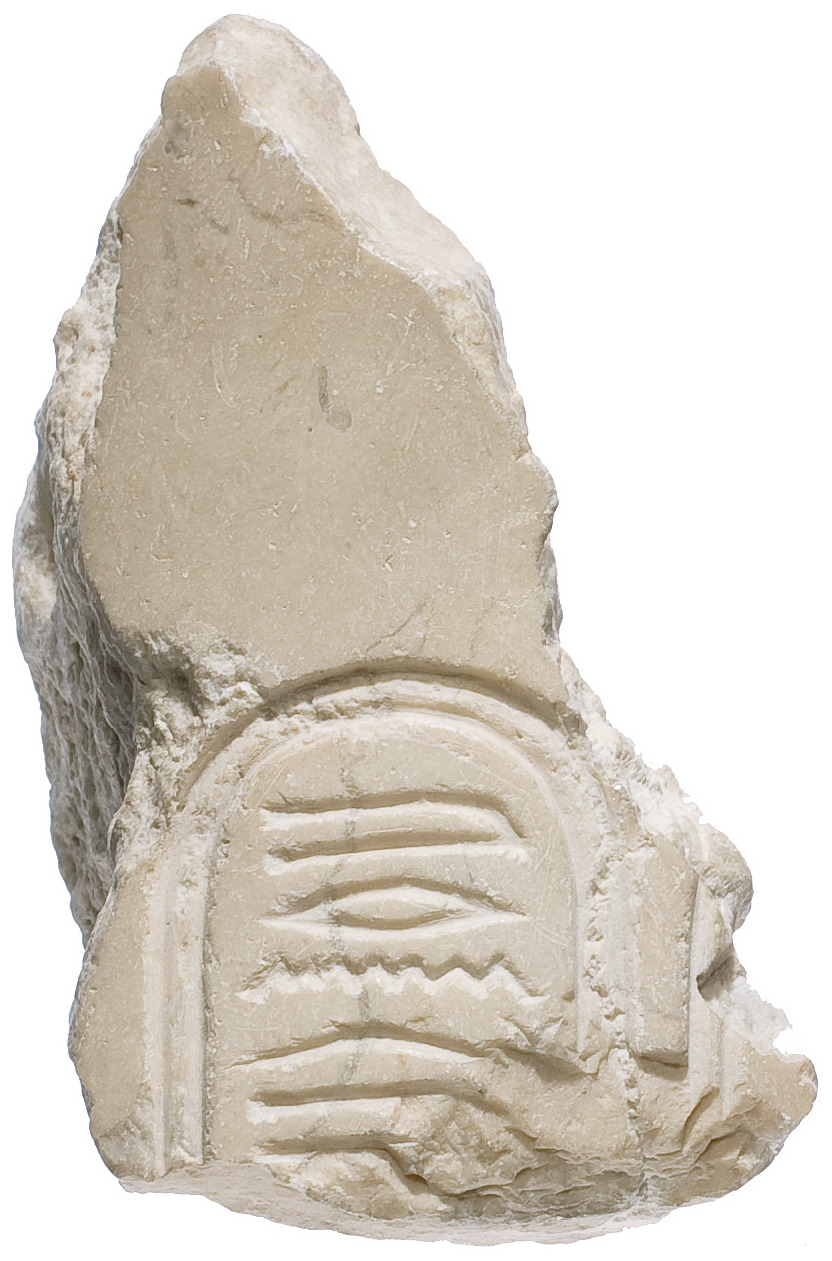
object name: arm at shoulder, aten cartouch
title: Right shoulder with Aten cartouche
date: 1353-1336 BCE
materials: limestone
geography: egypt